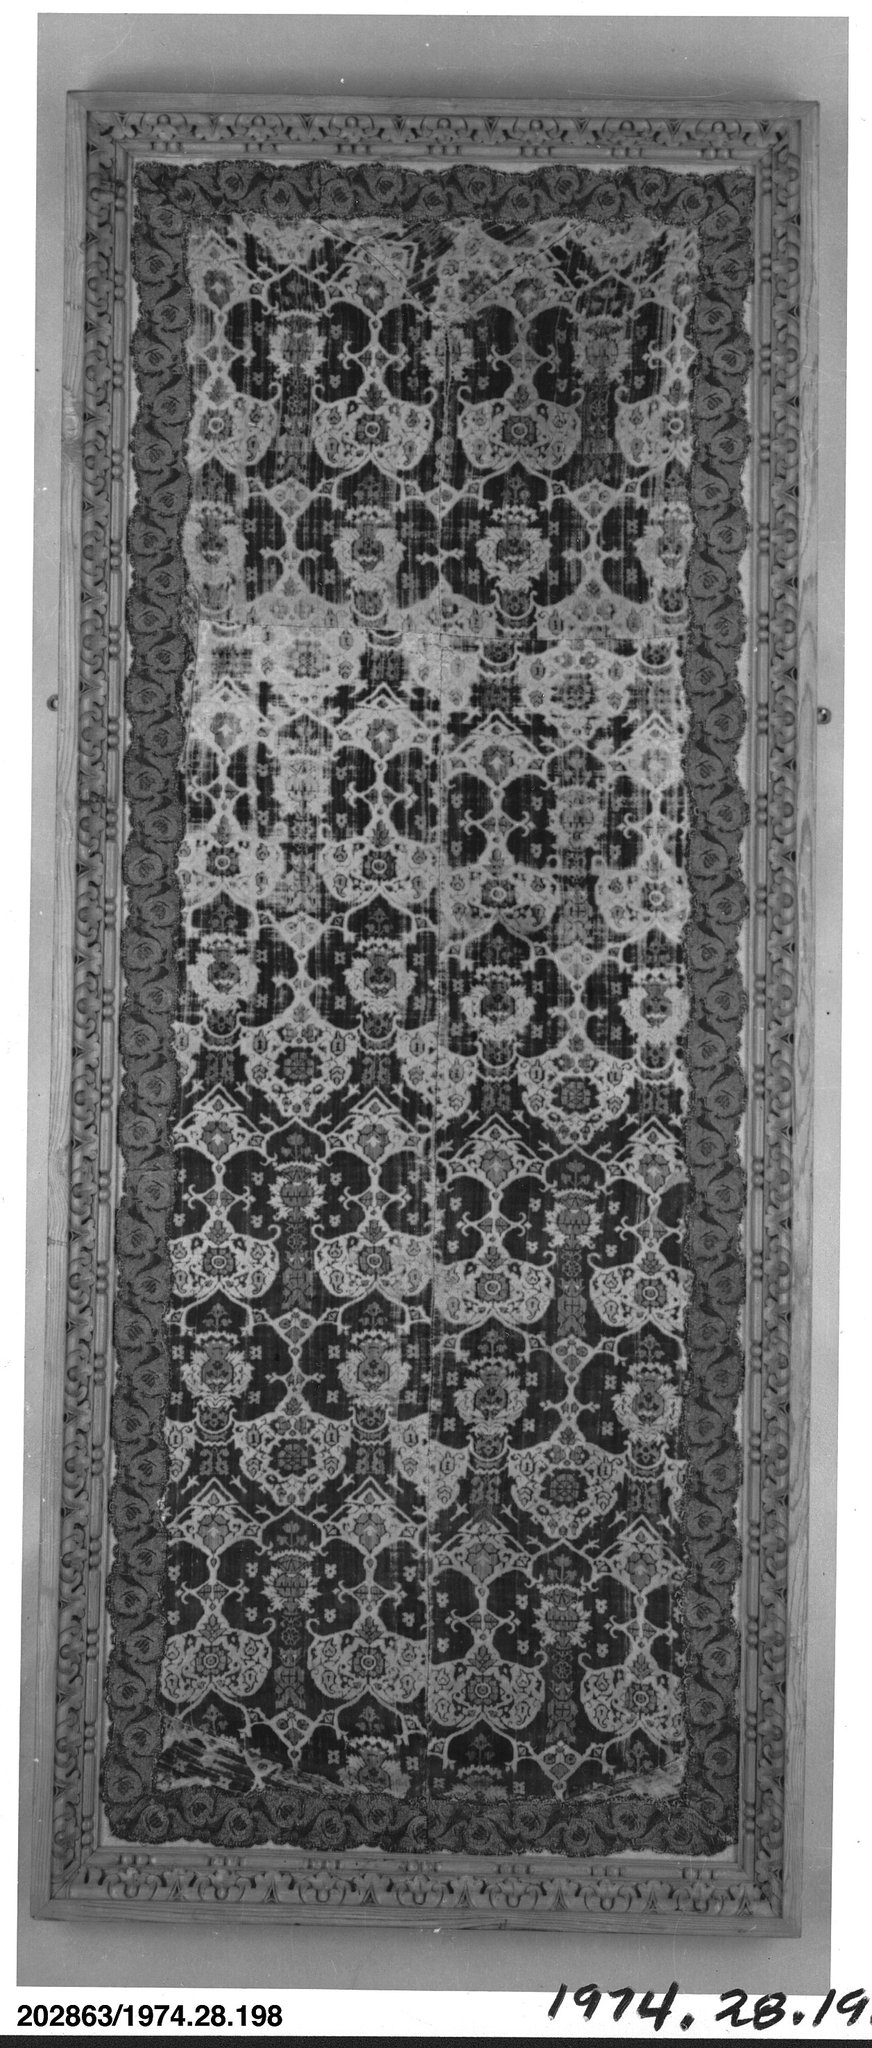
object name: panel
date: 1500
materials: silk